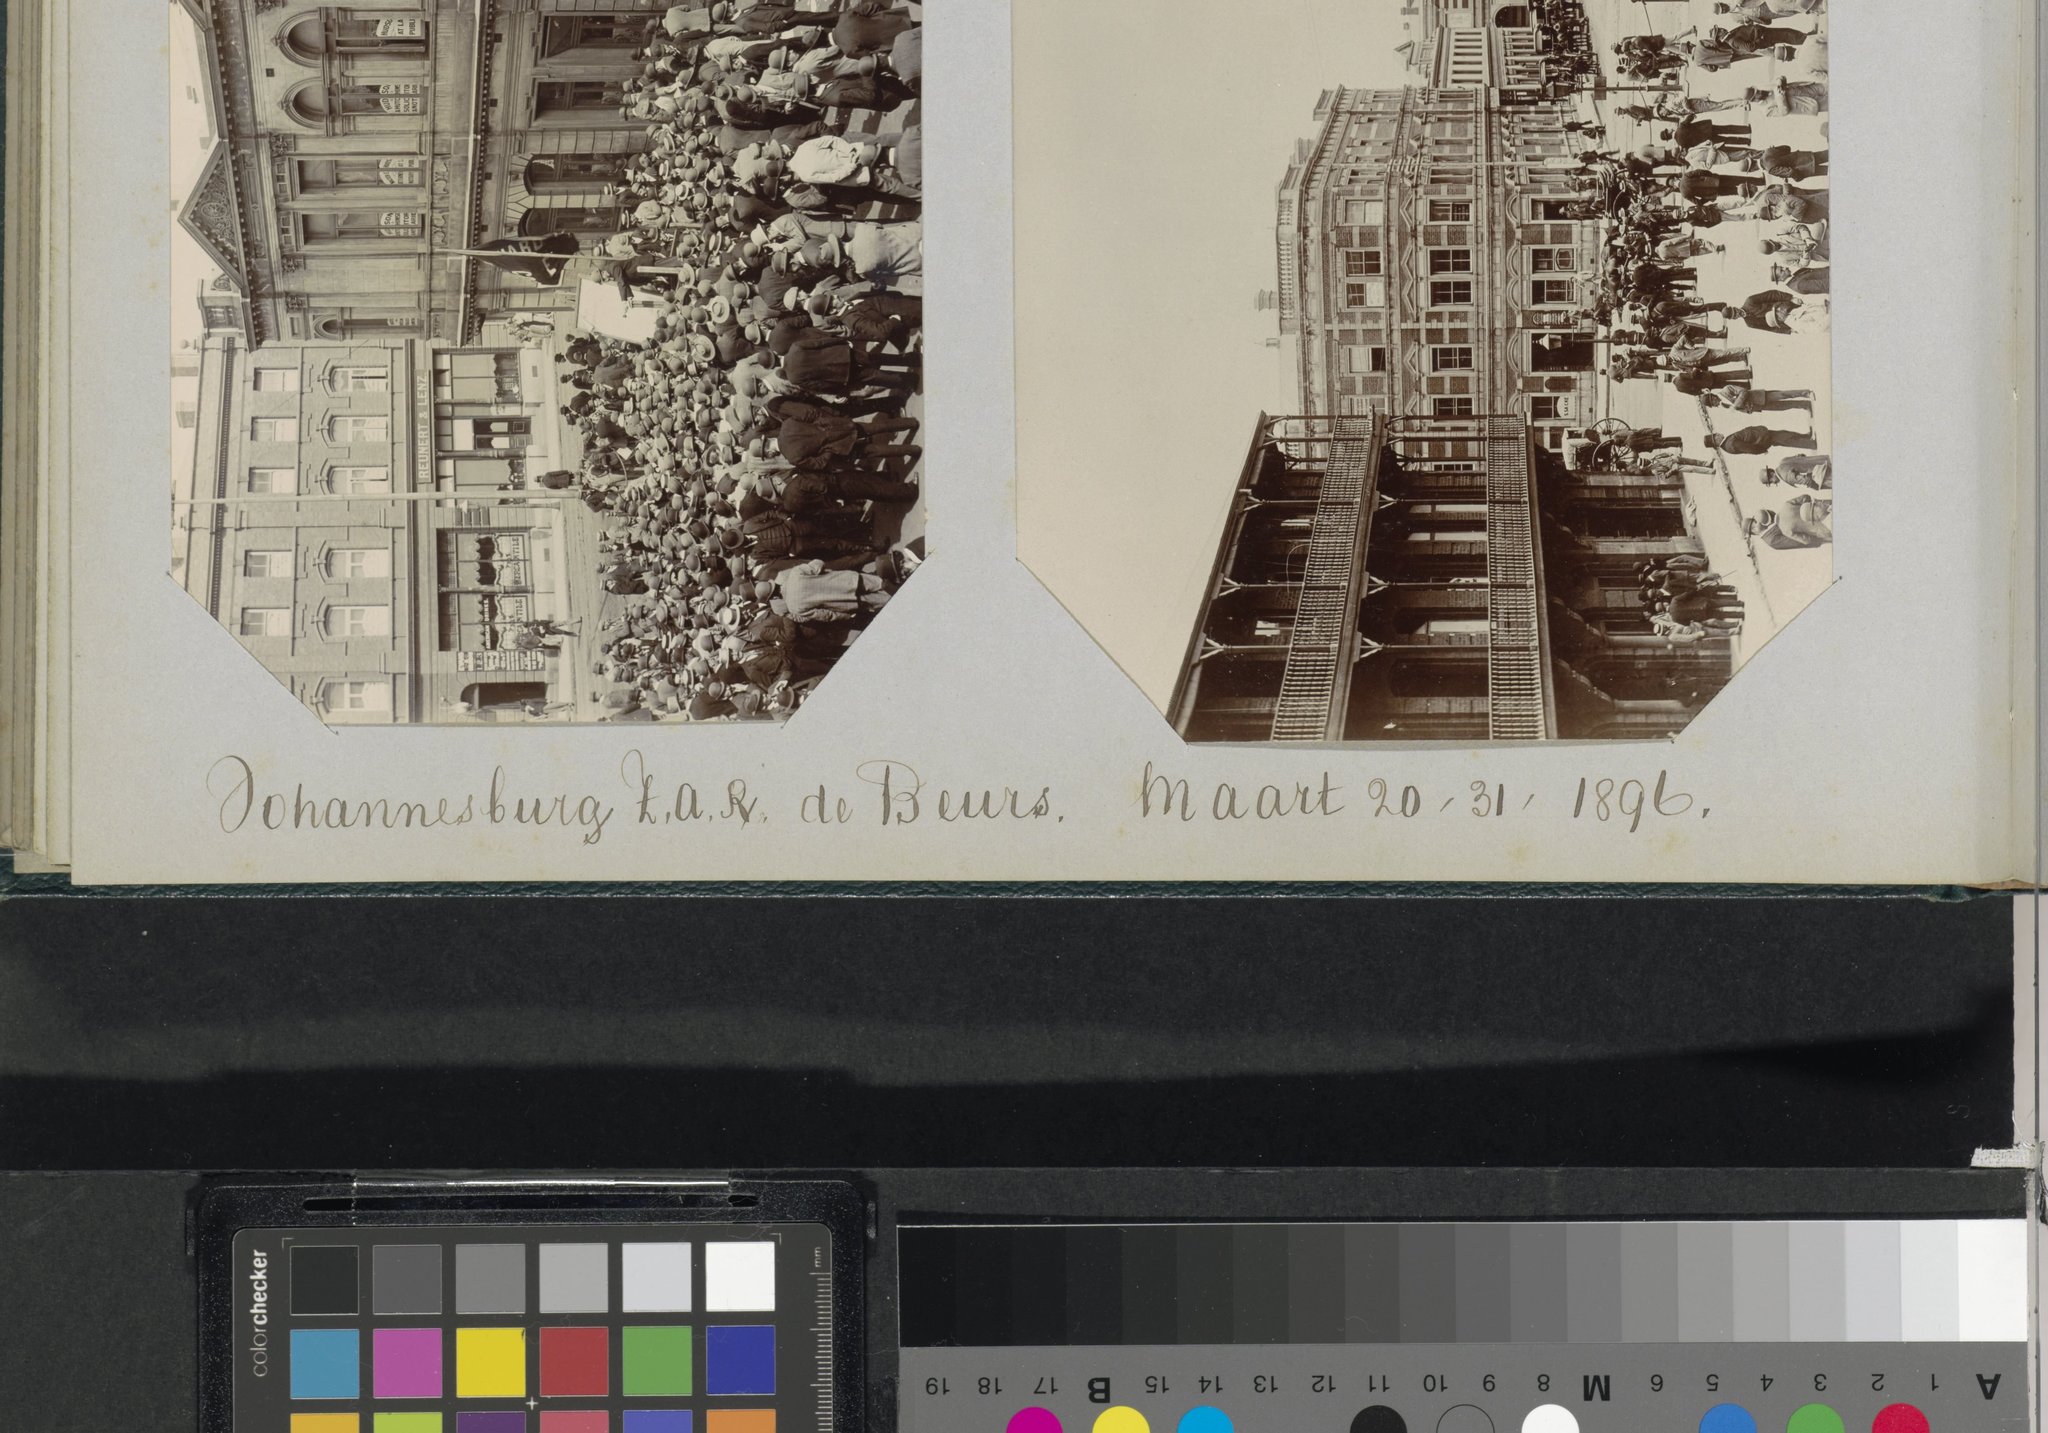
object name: photograph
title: Gezicht op het beursplein met handelaren te Johannesburg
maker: james f. goch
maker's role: fotograaf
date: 1896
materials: photographic support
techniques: albumen print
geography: johannesburg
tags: stock exchange, stock-market, square, place, circus, etc. (+ city(-scape) with figures, staffage), johannesburg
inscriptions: inscription: ‘Between the chains/ Goch/ No 82’, annotation: ‘Johannesburg Z.A.R. de Beurs. maart 20/31 1896’